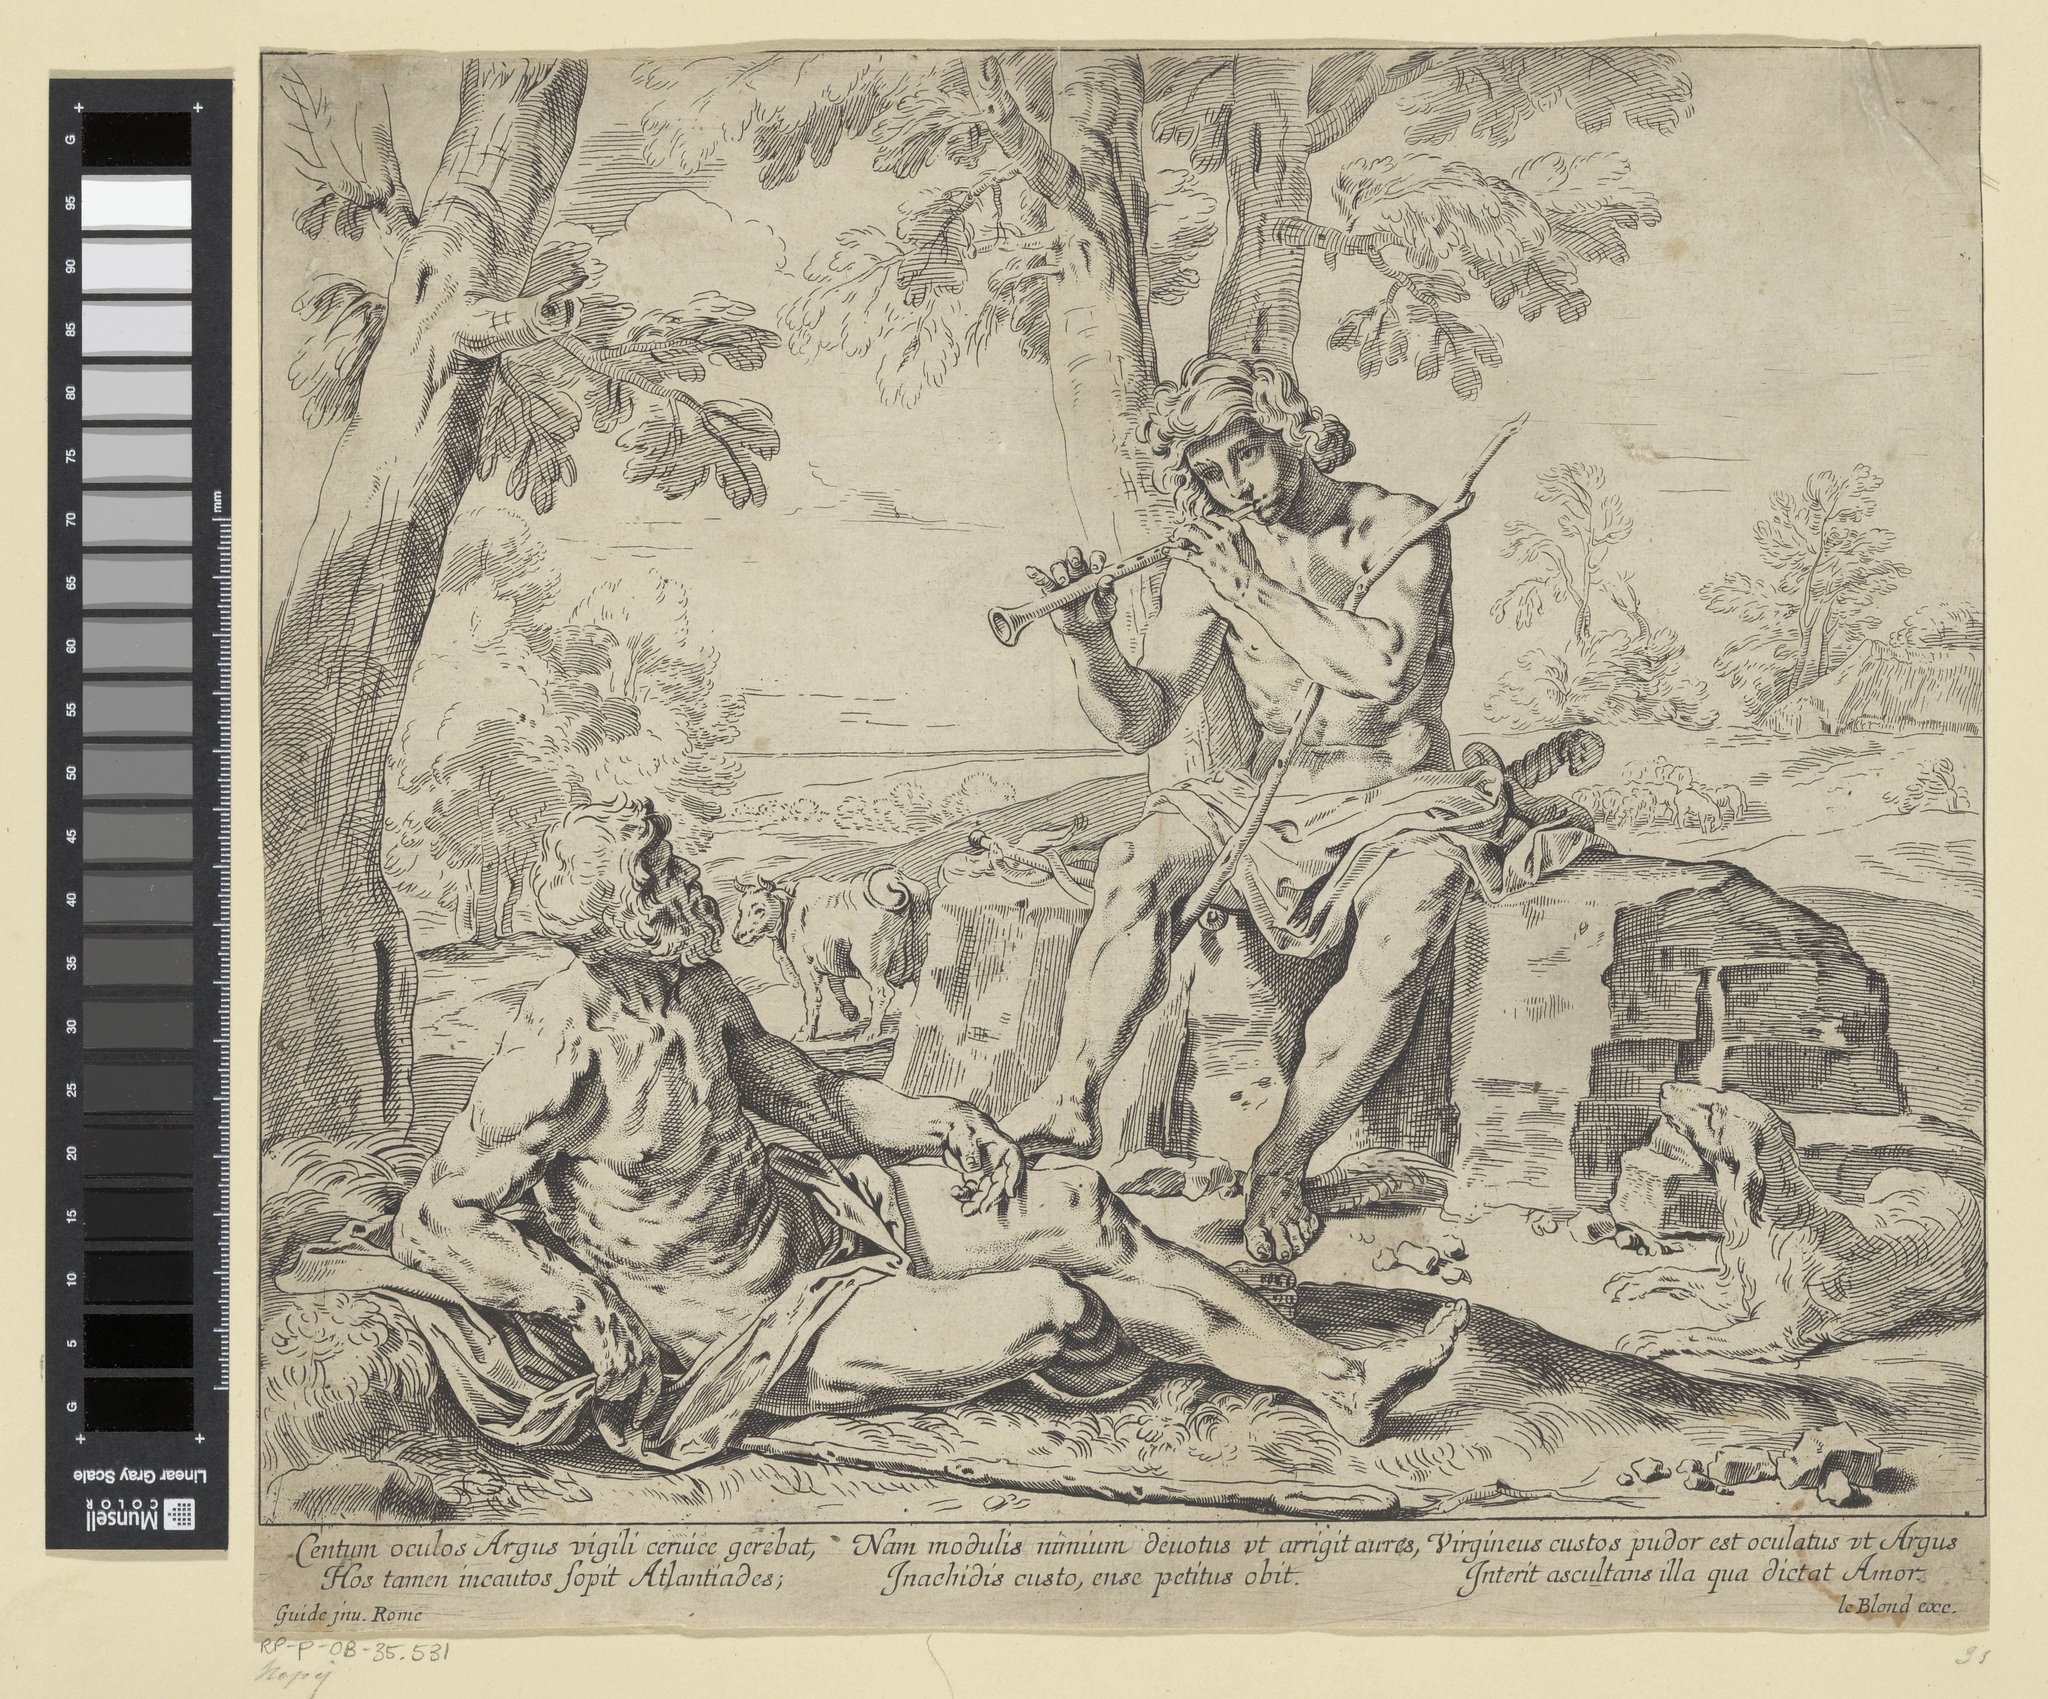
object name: print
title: Mercurius en Argus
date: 1622-1648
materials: paper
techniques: etching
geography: italy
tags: mercury lulls argus into sleep by making music, io as a cow watched by argus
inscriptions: collector's mark: Lugt 240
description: Mercurius zit op een rots en speelt op een fluit. Hij probeert Argus in slaap te sussen met zijn muziek, om hem vervolgens te kunnen vermoorden. Argus zit op de voorgrond links. Op de achtergrond Io in de gedaante van een koe. Tekst in ondermarge.